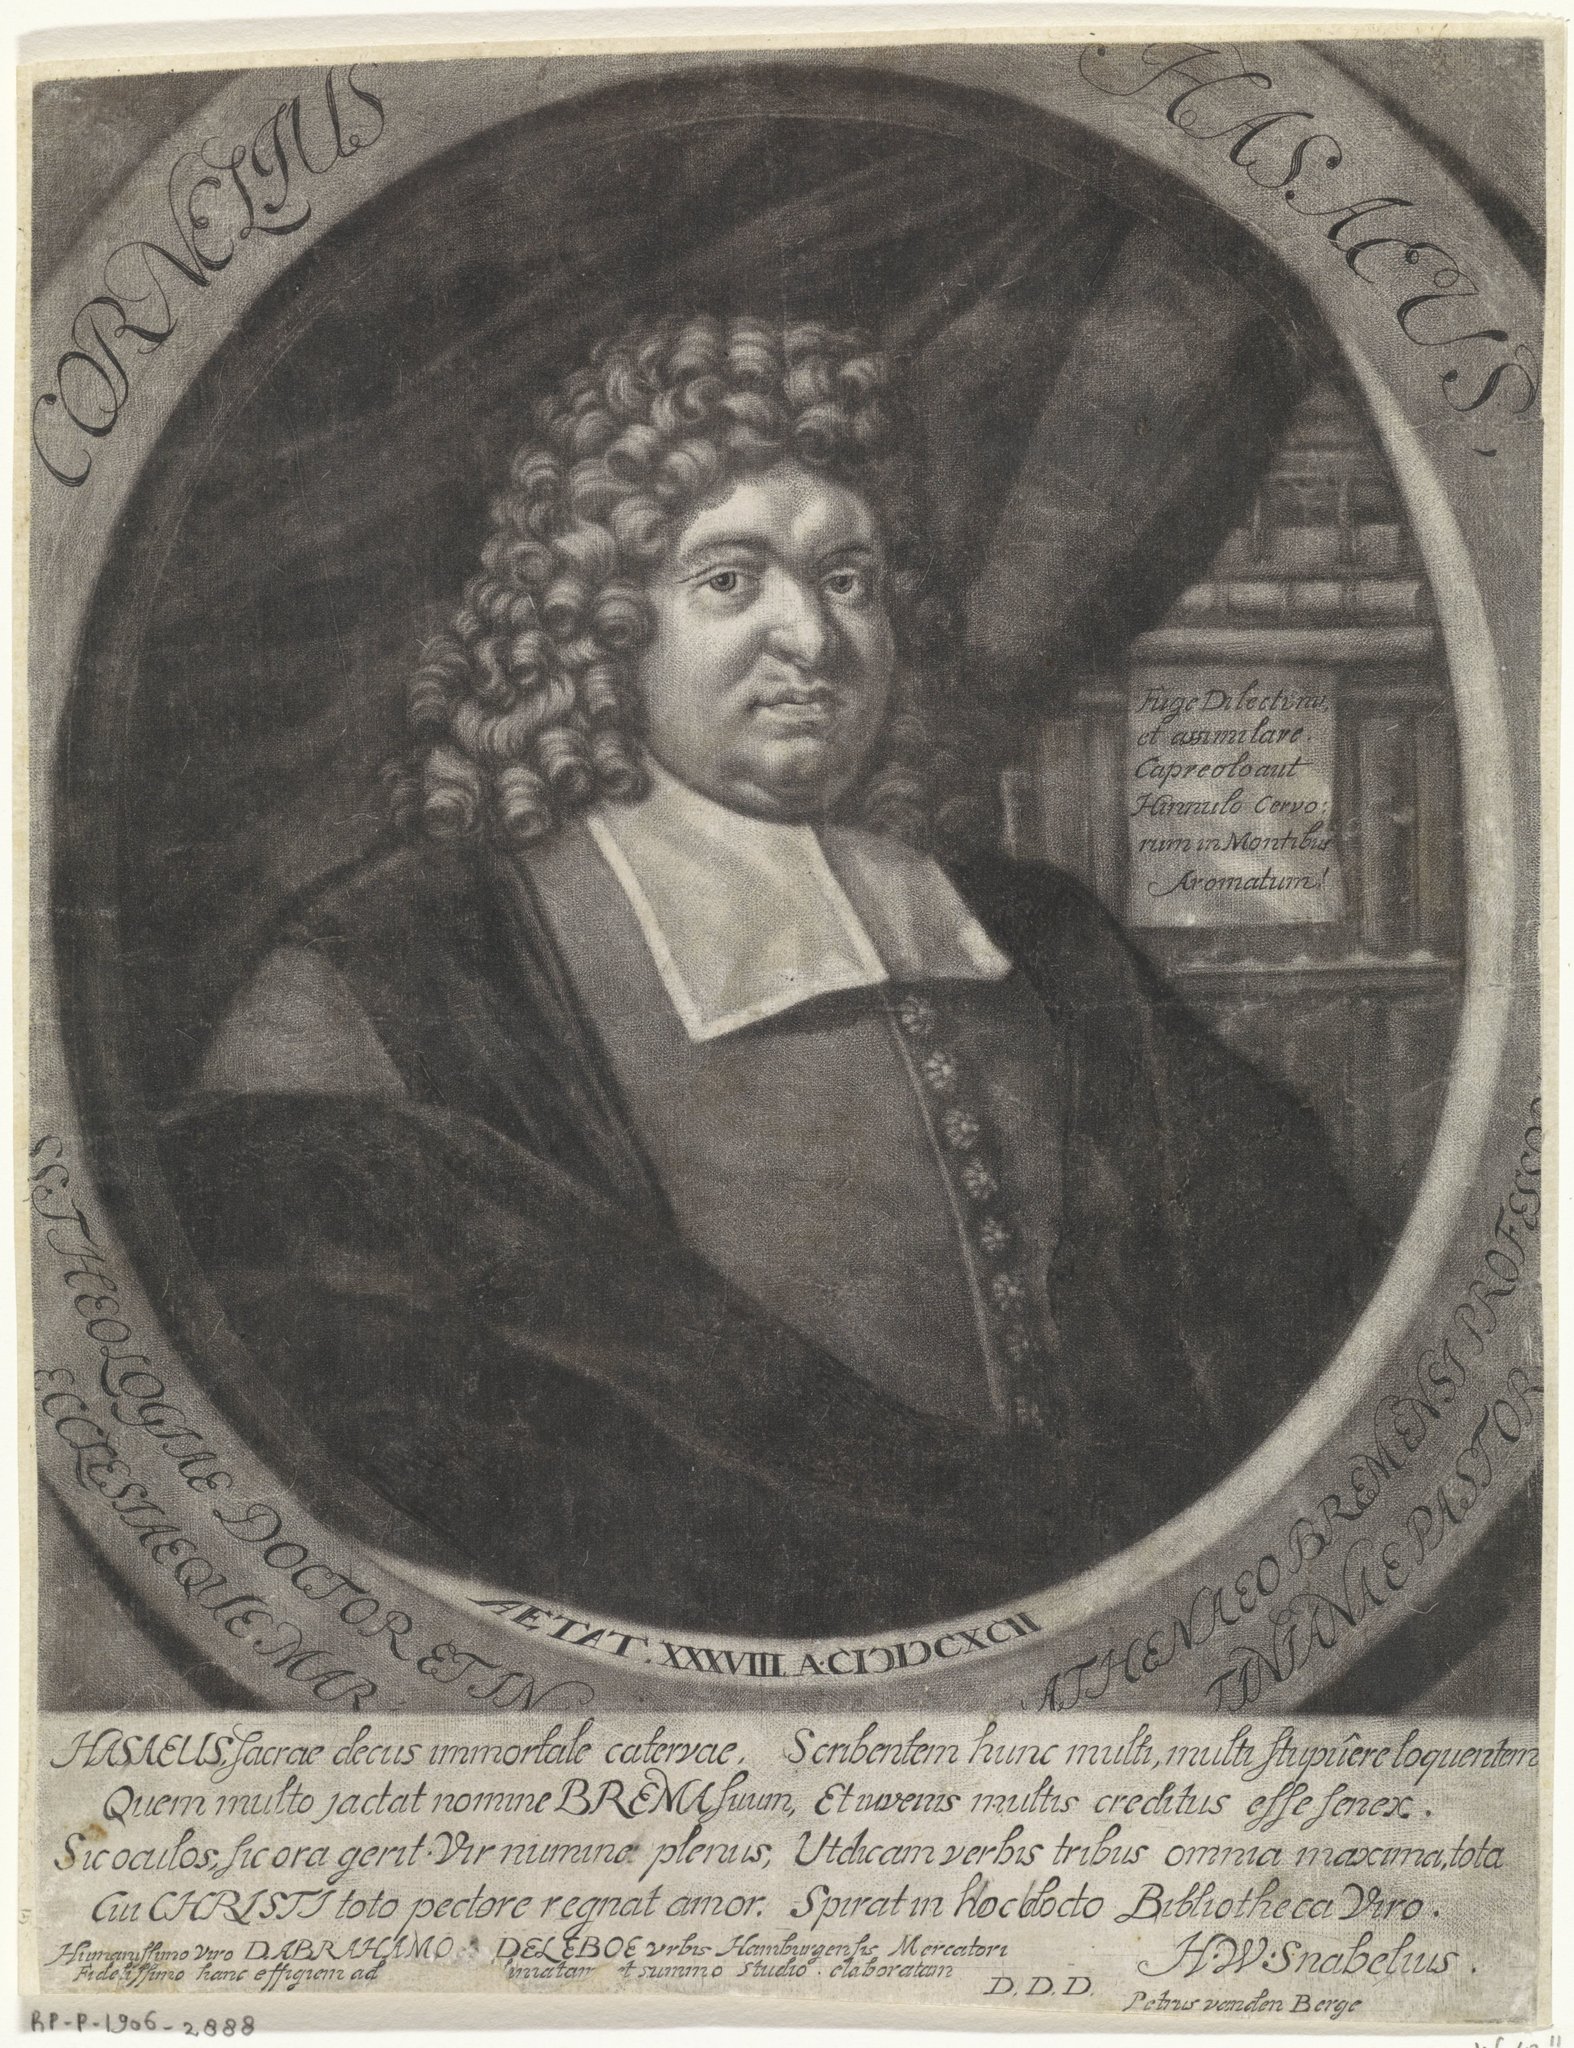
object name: print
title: Portret van Cornelius Hasaeus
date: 1692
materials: paper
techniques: engraving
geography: hamburg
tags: wig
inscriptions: collector's mark: Lugt 2228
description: Portret van de Duitse theoloog en schrijver Cornelius Hasaeus (Cornelius de Hase) op 38-jarige leeftijd. Achter hem een boekenkast. In de omlijsting zijn naam, leeftijd en titels. In de marge een vierregelig gedicht.